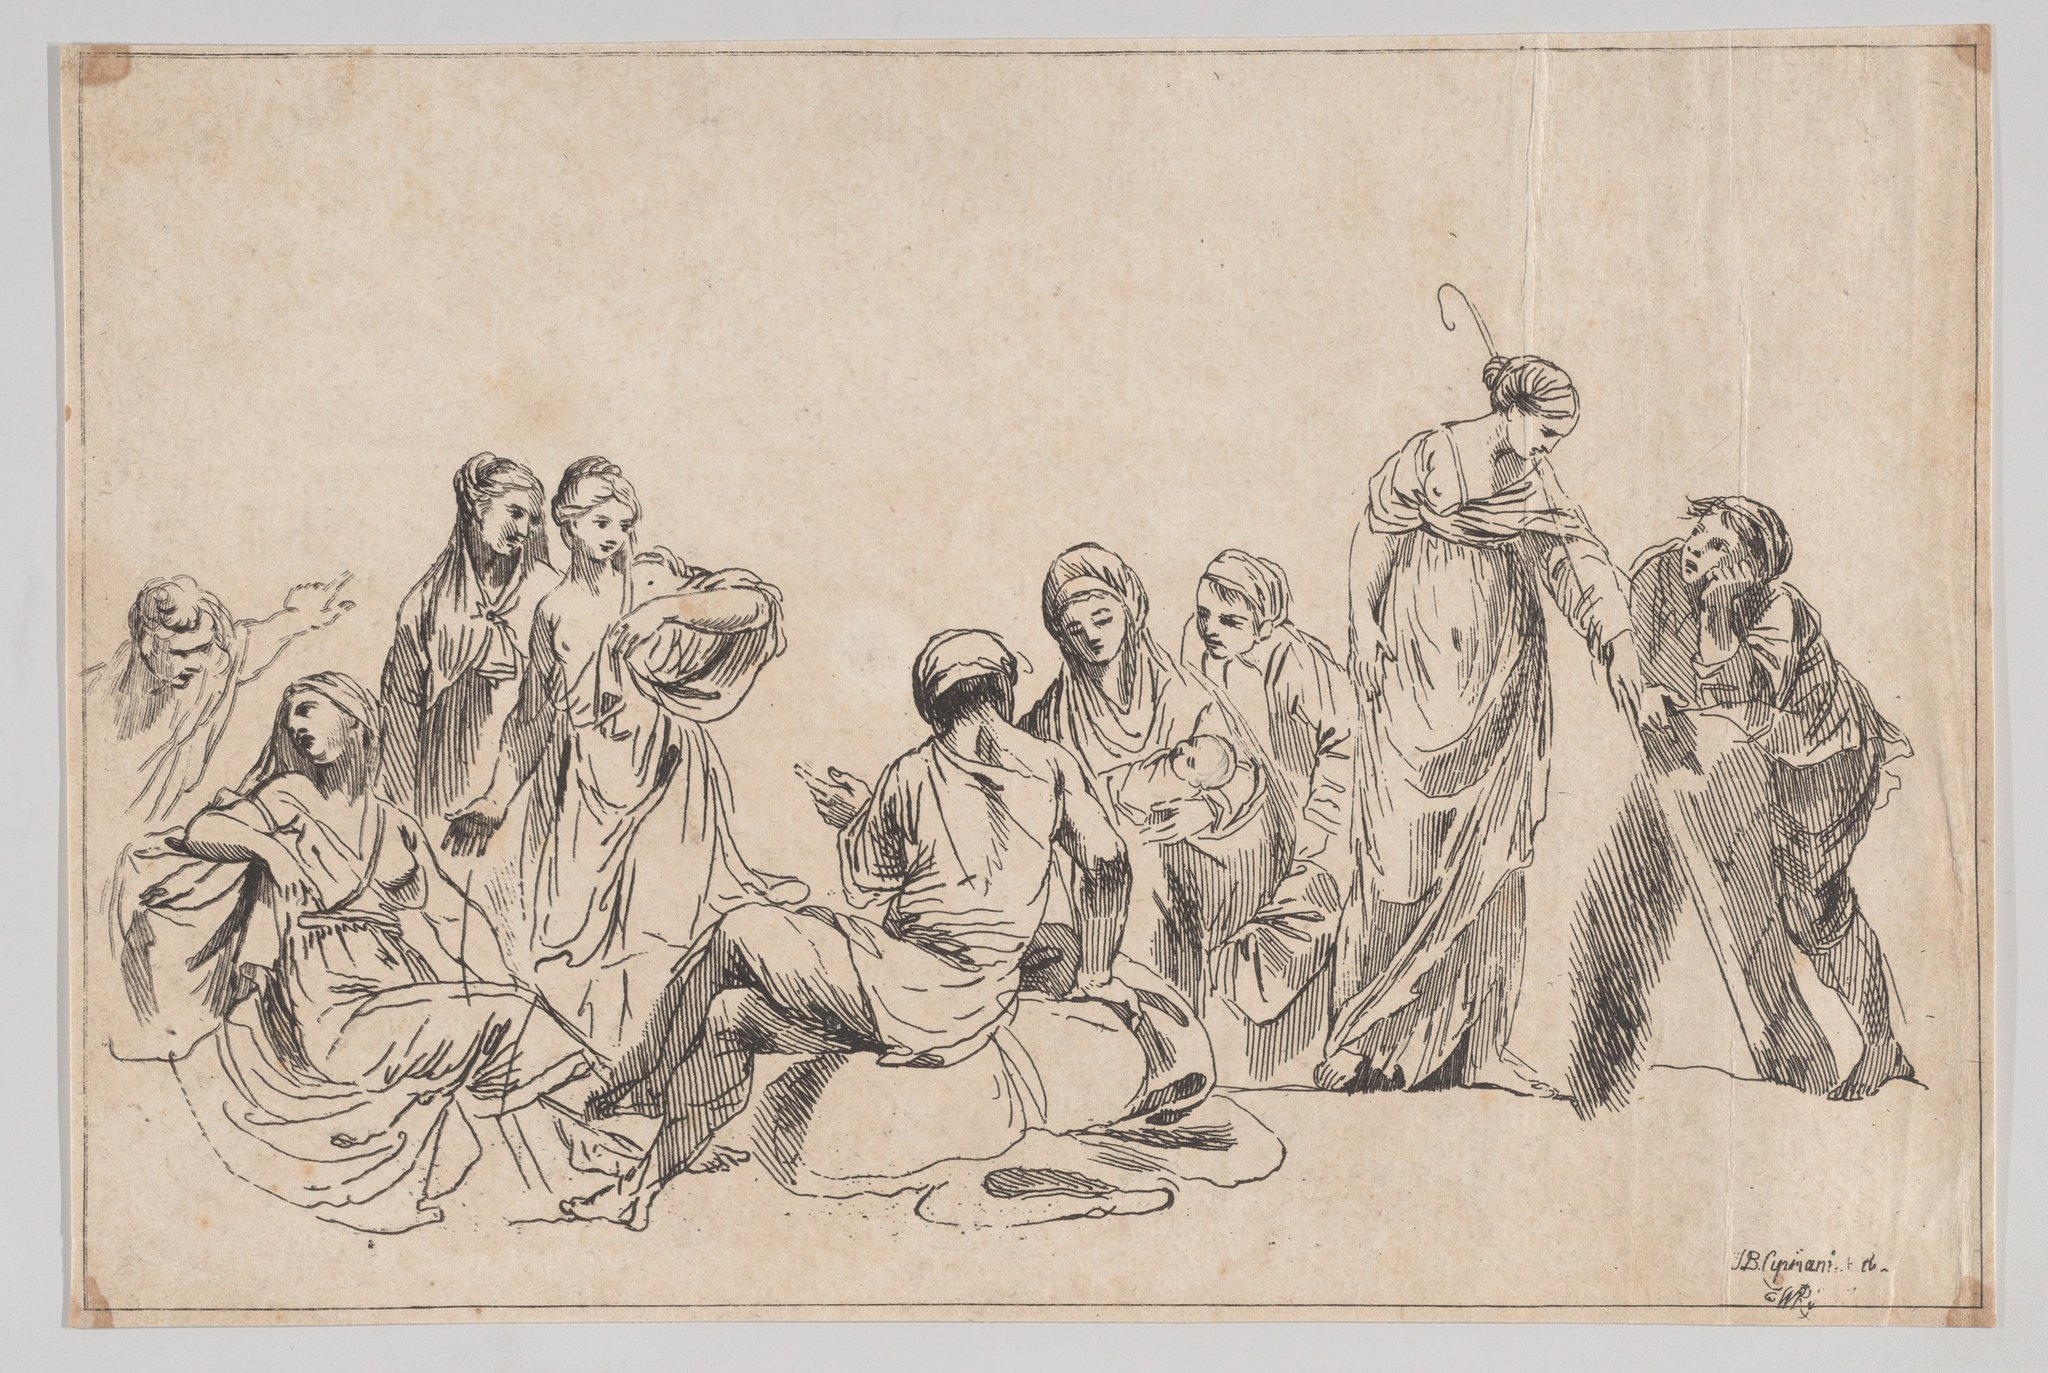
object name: print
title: A group of nine women, one at center holds a baby and one at right holds a shepherdess's crook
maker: Anonymous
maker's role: artist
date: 1750-1850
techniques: etching